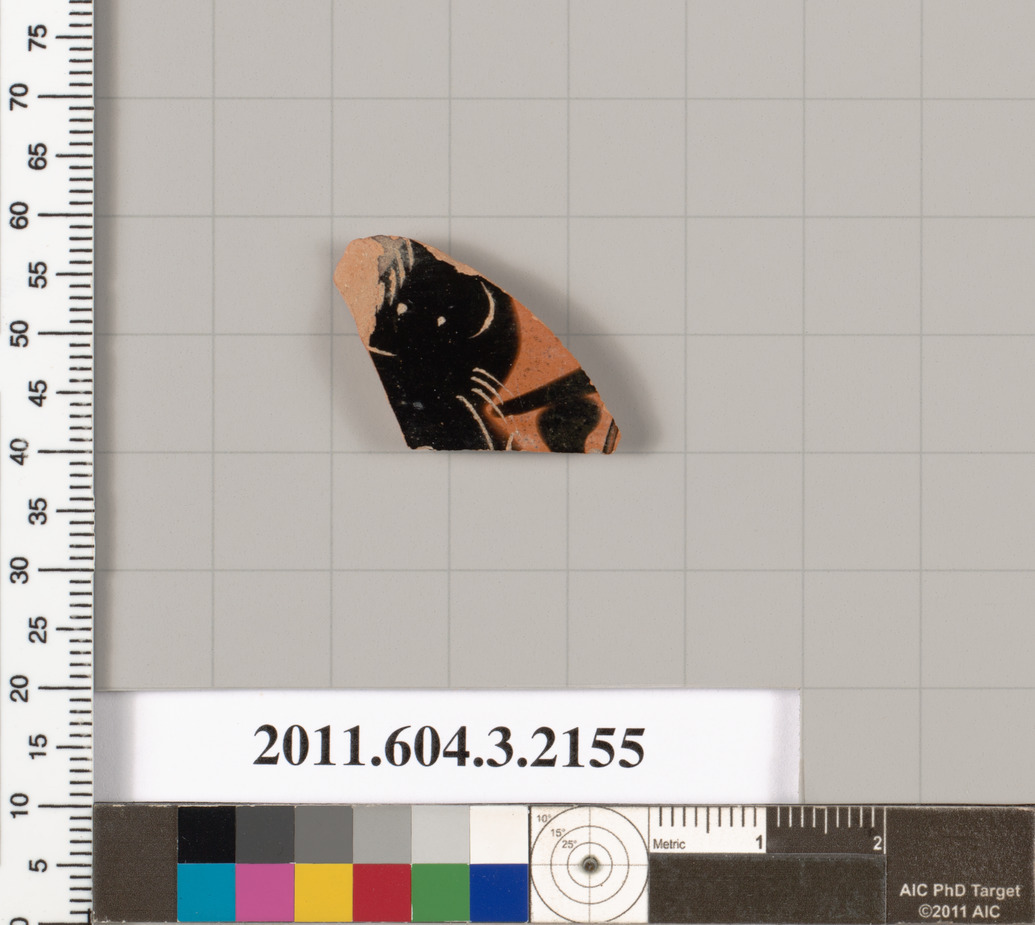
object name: kylix fragment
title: Terracotta fragment of a kylix (drinking cup)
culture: greek, attic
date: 534-501 BCE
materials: terracotta